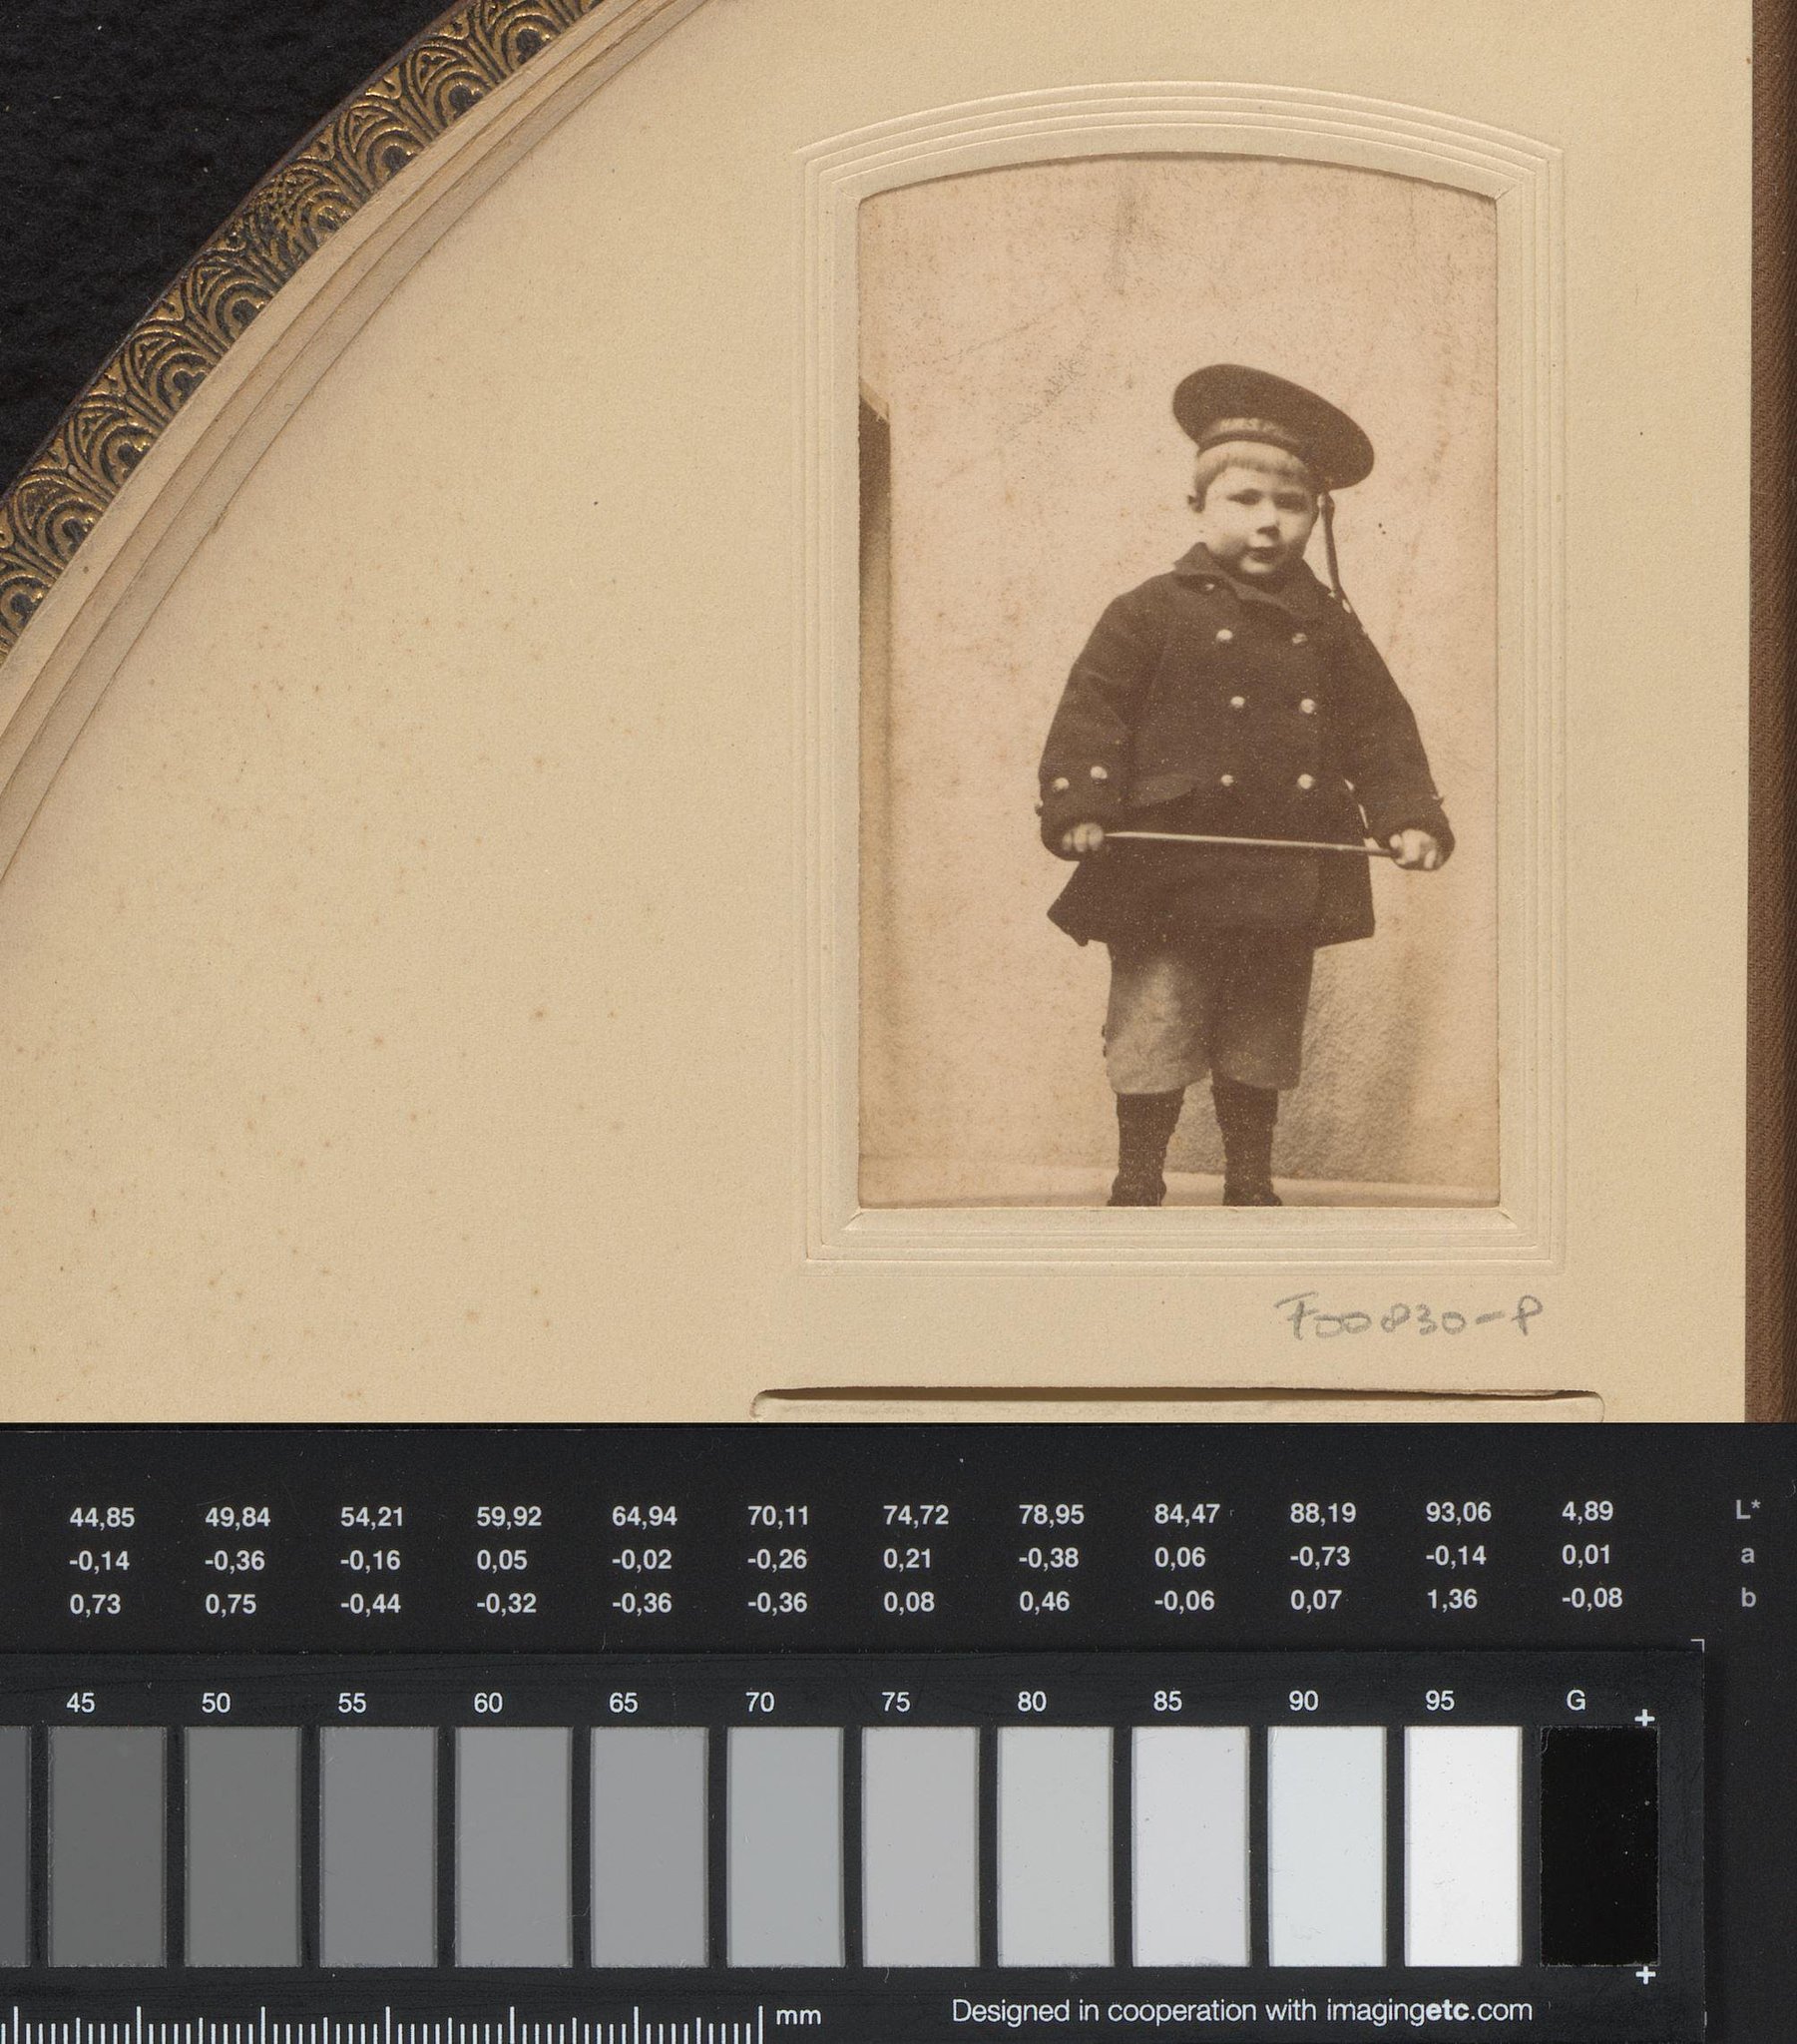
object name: carte de visite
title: Portret van een staand kind in jas met pet en stok in de hand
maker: Anonymous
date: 1880-1900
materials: cardboard, photographic support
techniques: albumen print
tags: child, historical persons